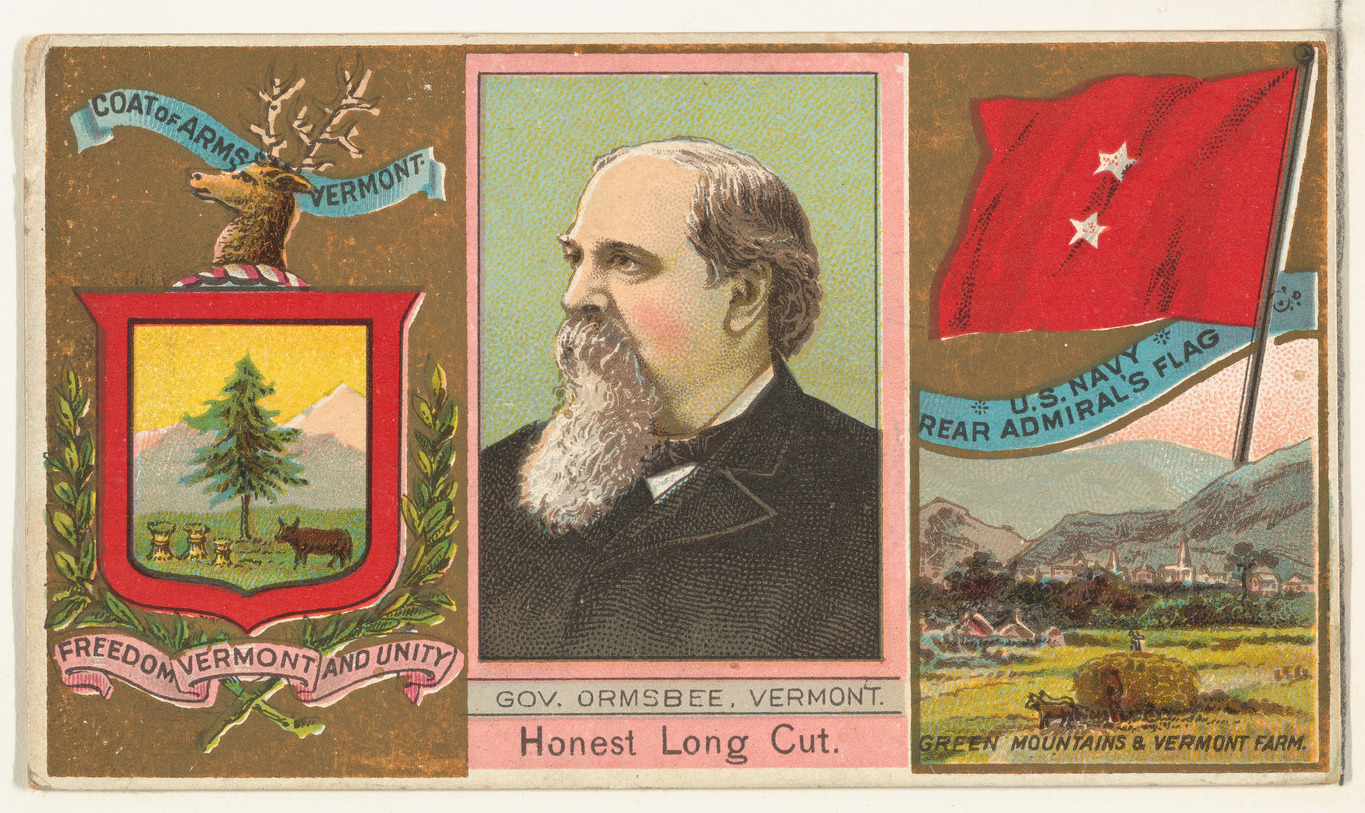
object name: print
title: Governor Ormsbee, Vermont, from "Governors, Arms, Etc." series (N133-1), issued by Duke Sons & Co.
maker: w. duke, sons & co.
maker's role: publisher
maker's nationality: american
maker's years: 1870-1920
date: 1888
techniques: color lithograph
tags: men,profiles,coat of arms,flags